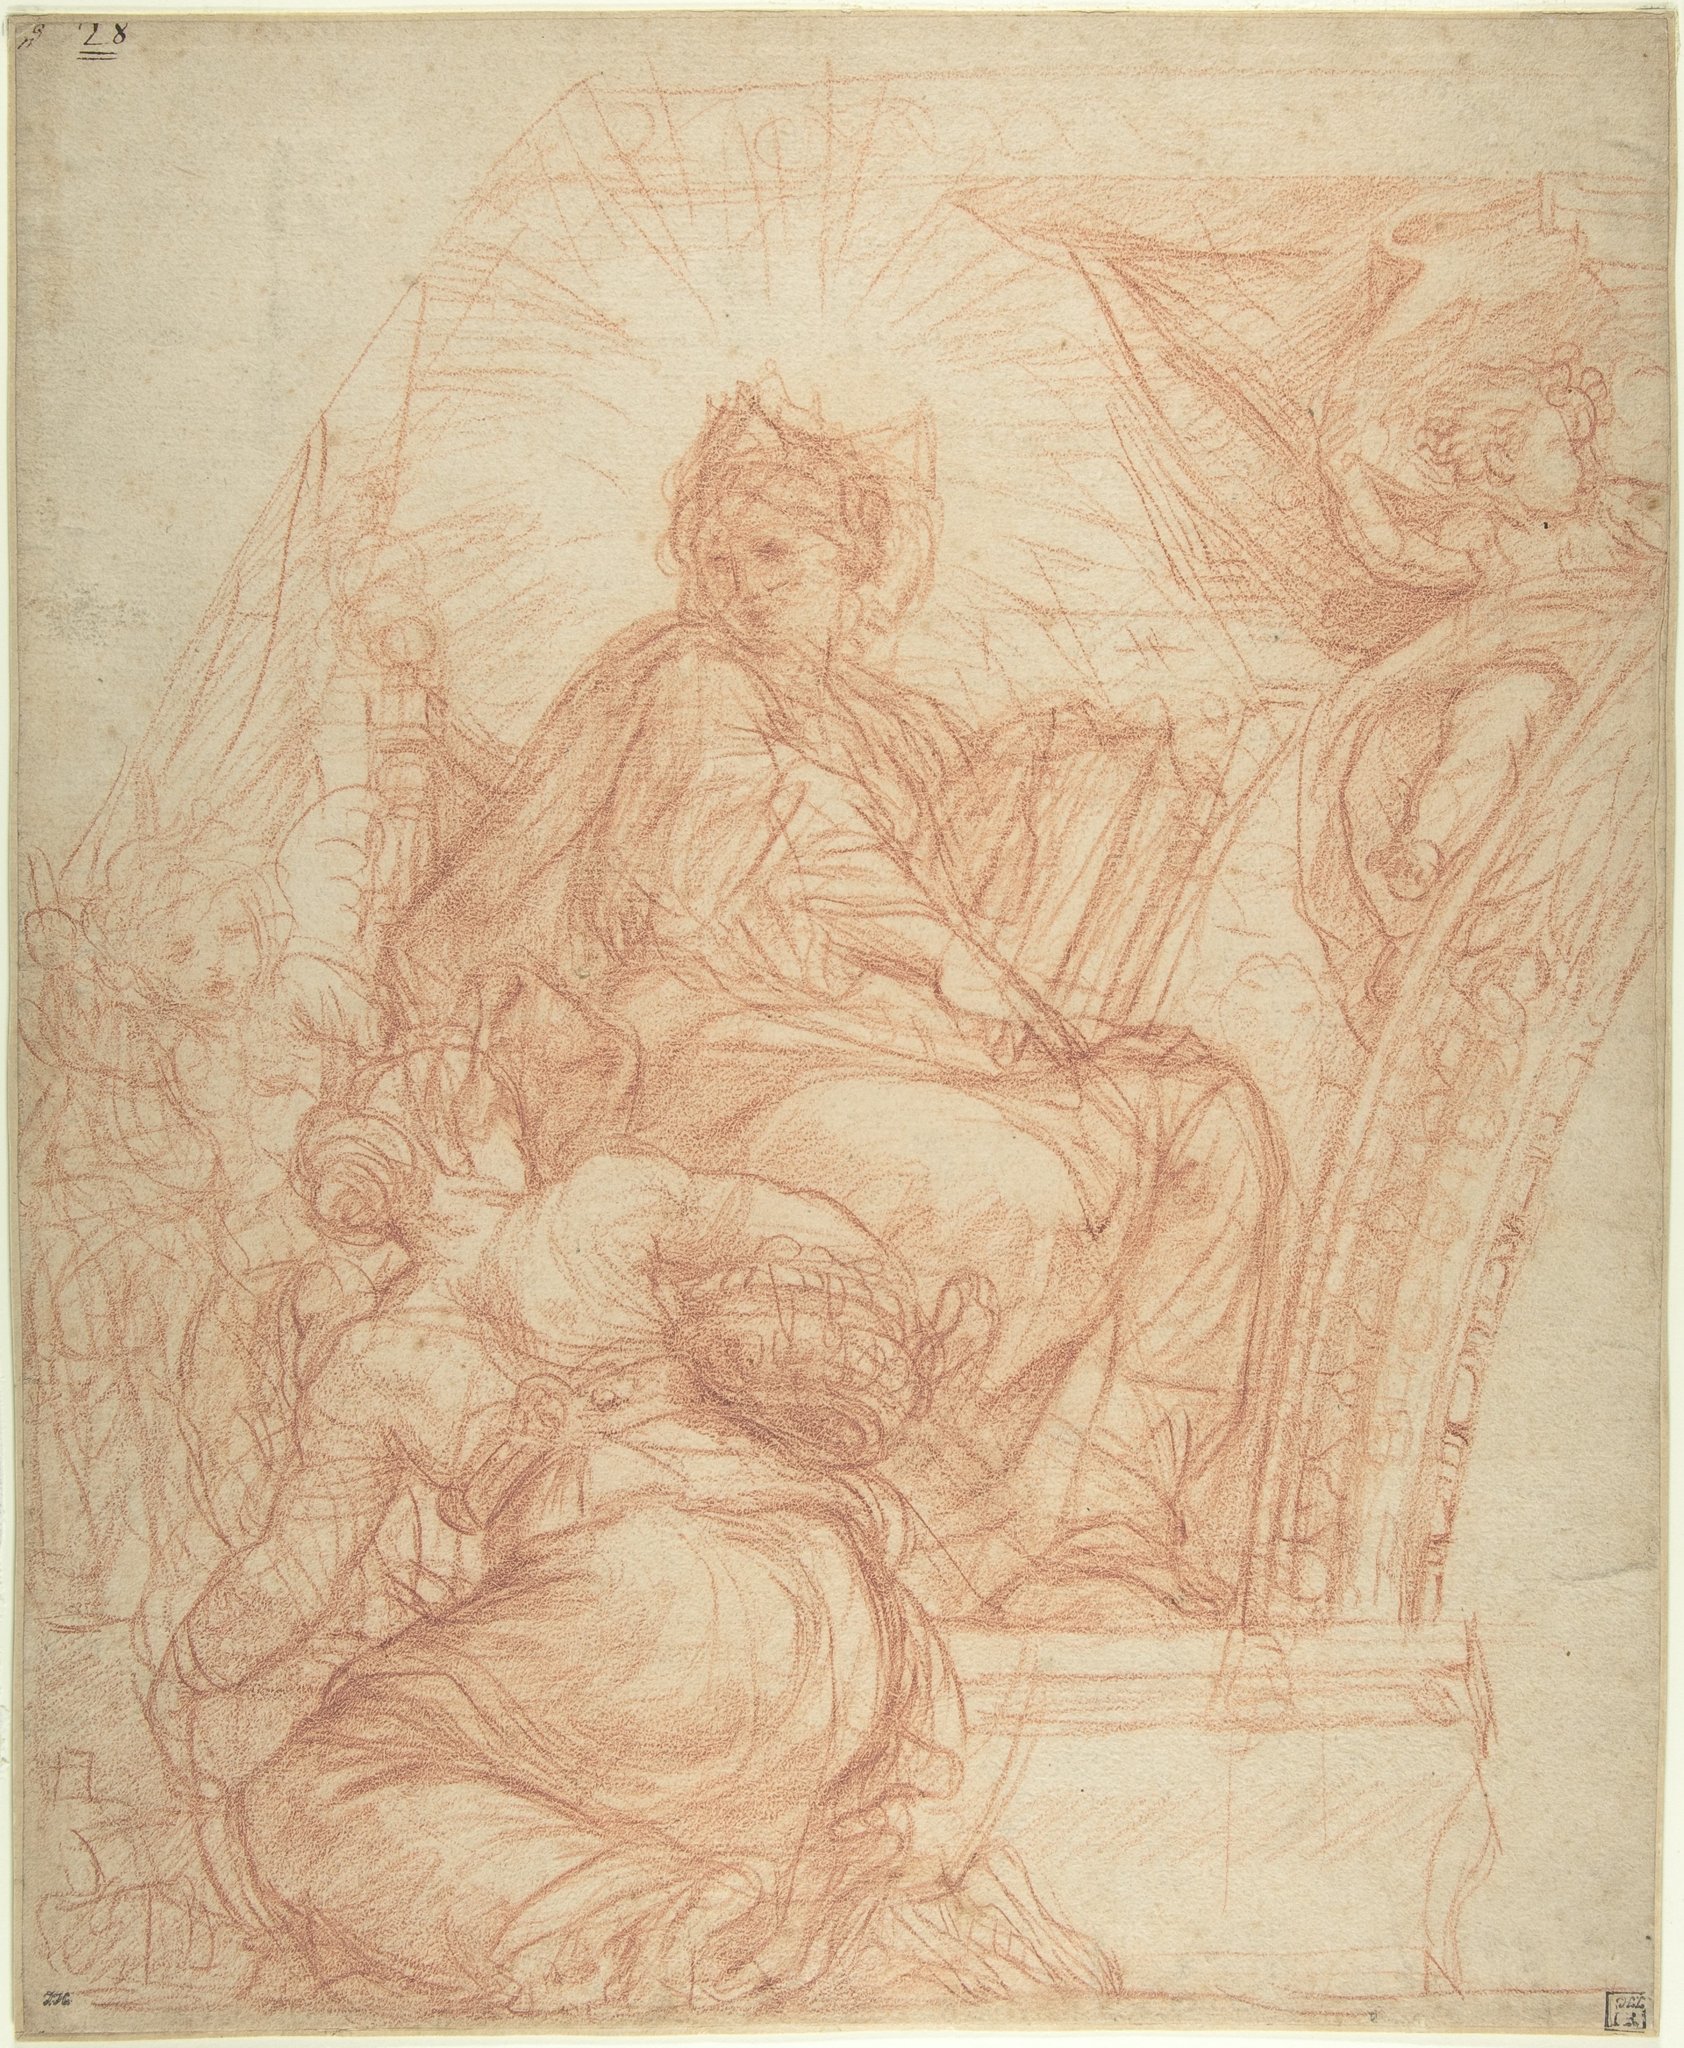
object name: drawing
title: Seated Allegorical Figure of Divine Wisdom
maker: carlo maratti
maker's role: artist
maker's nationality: italian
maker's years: 1625-1713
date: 1674-1677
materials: chalk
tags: infants,women